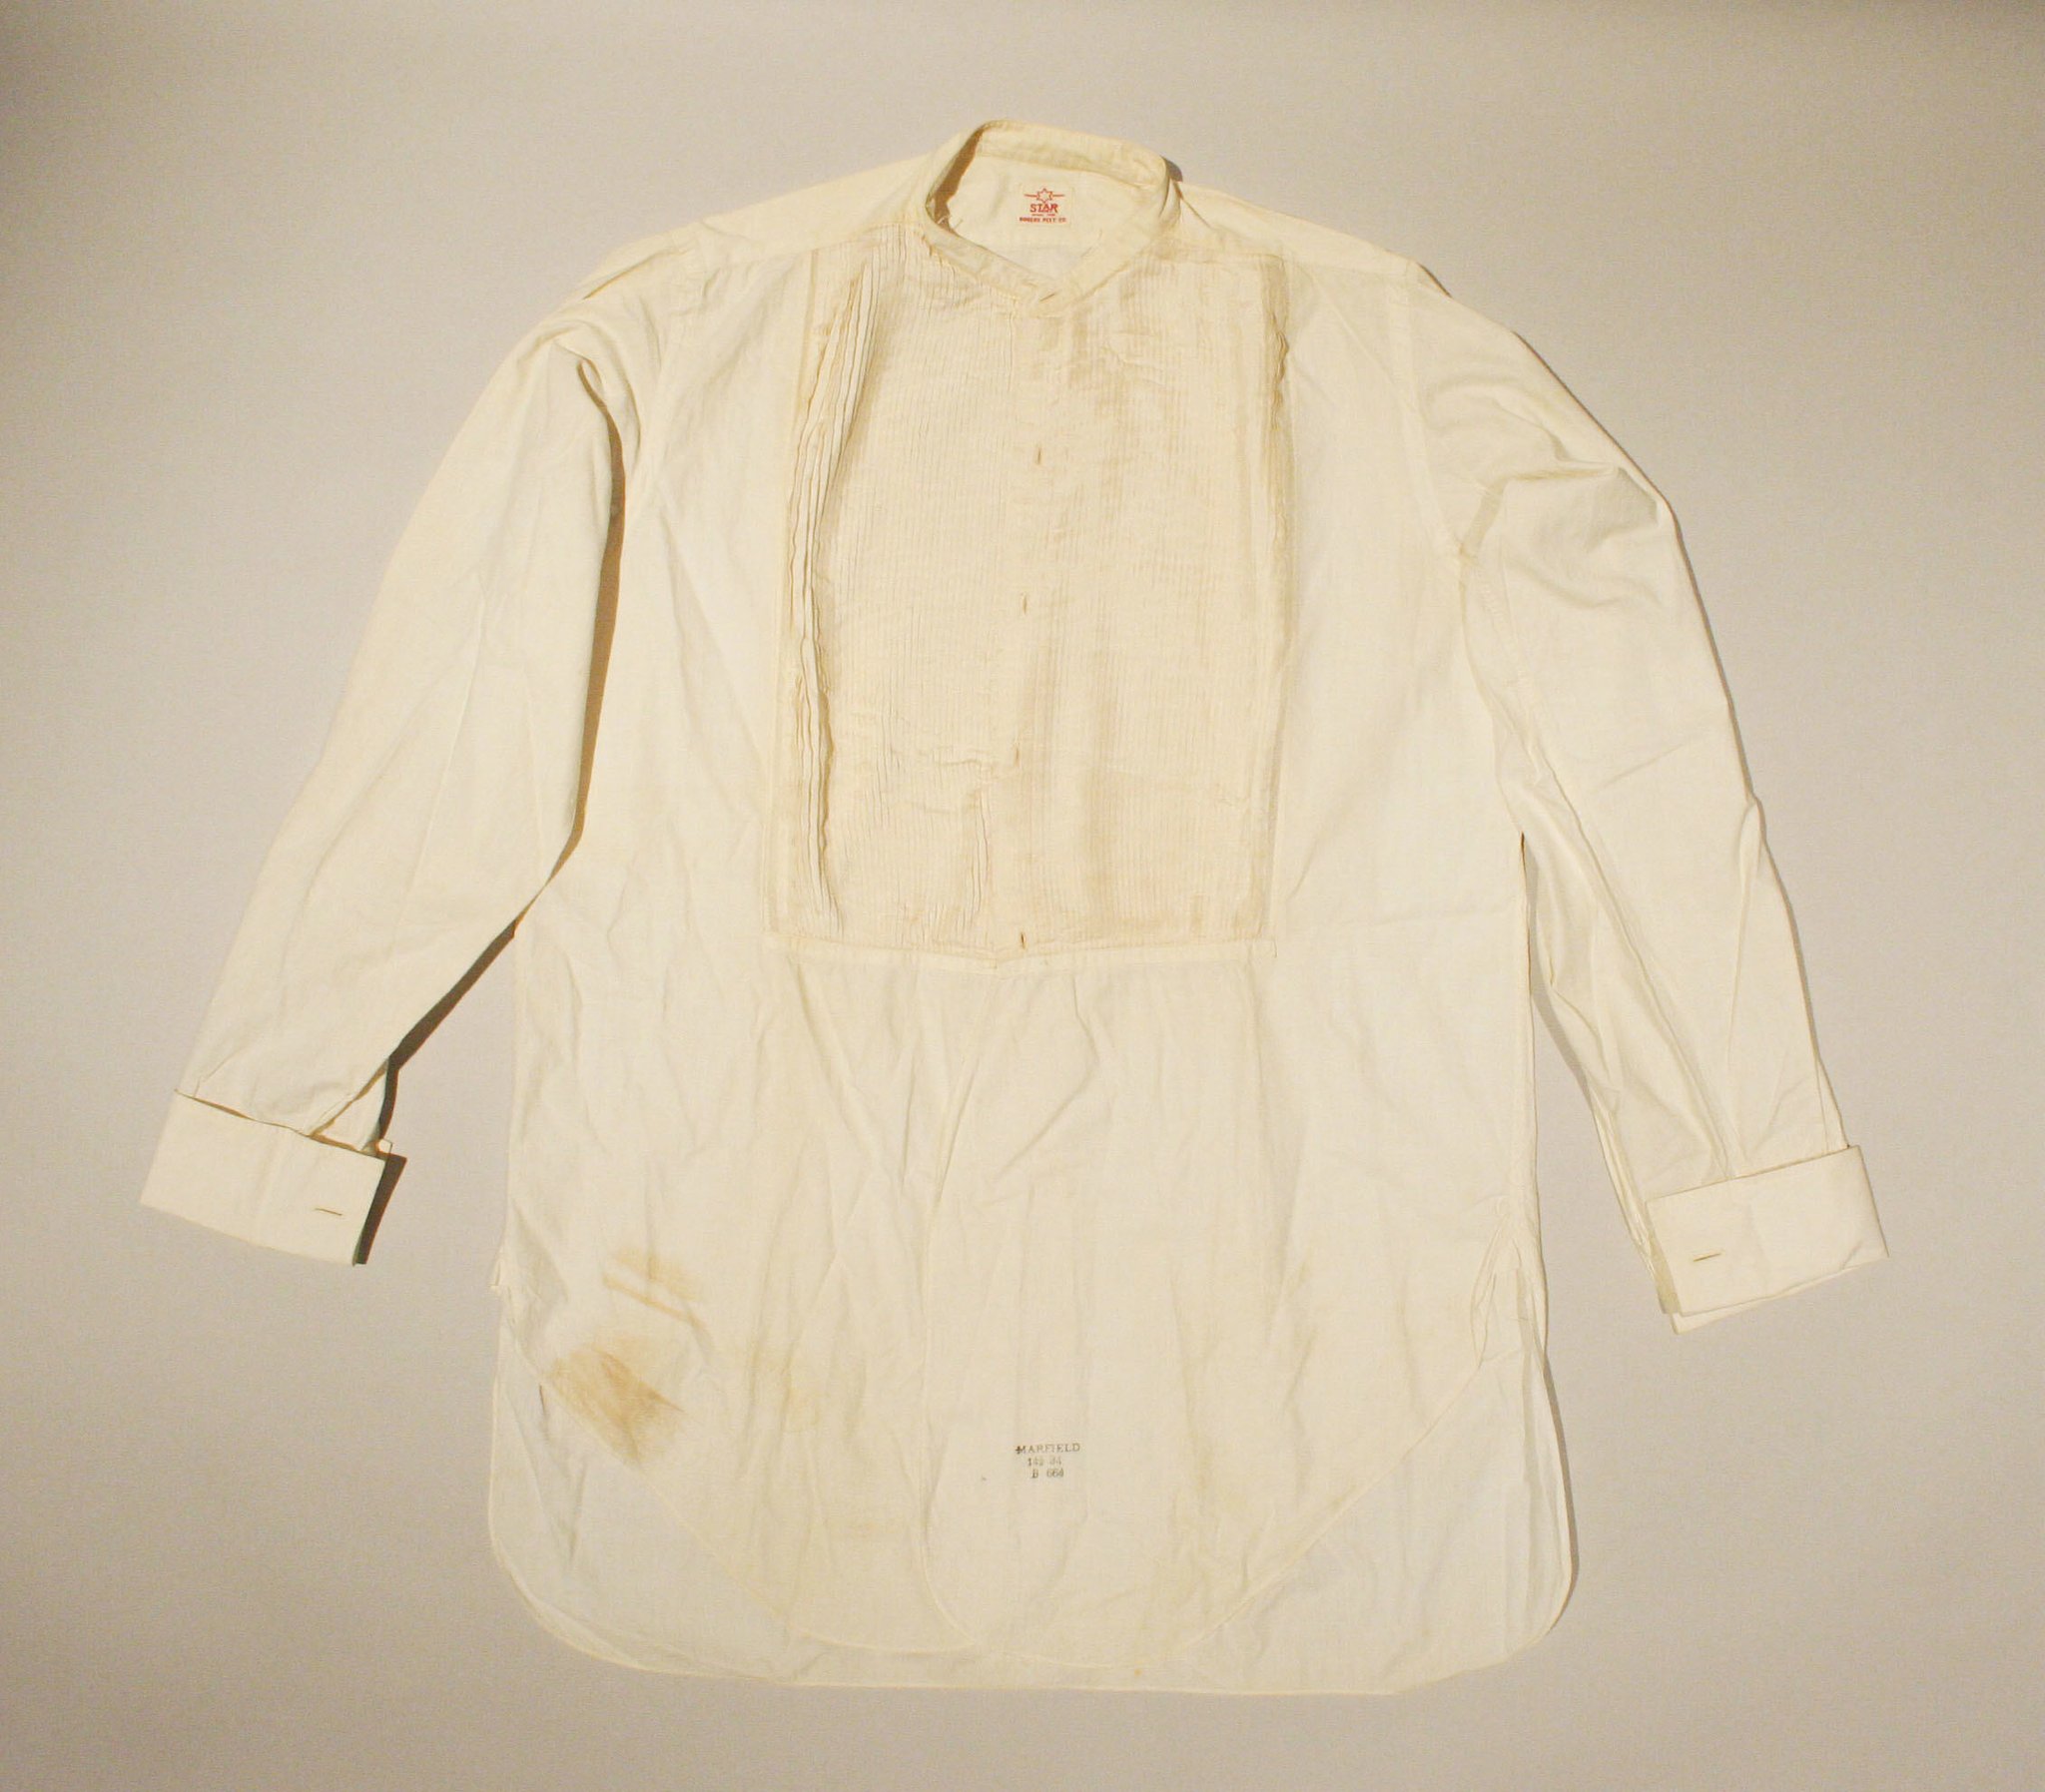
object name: dress shirt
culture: american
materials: linen, silk